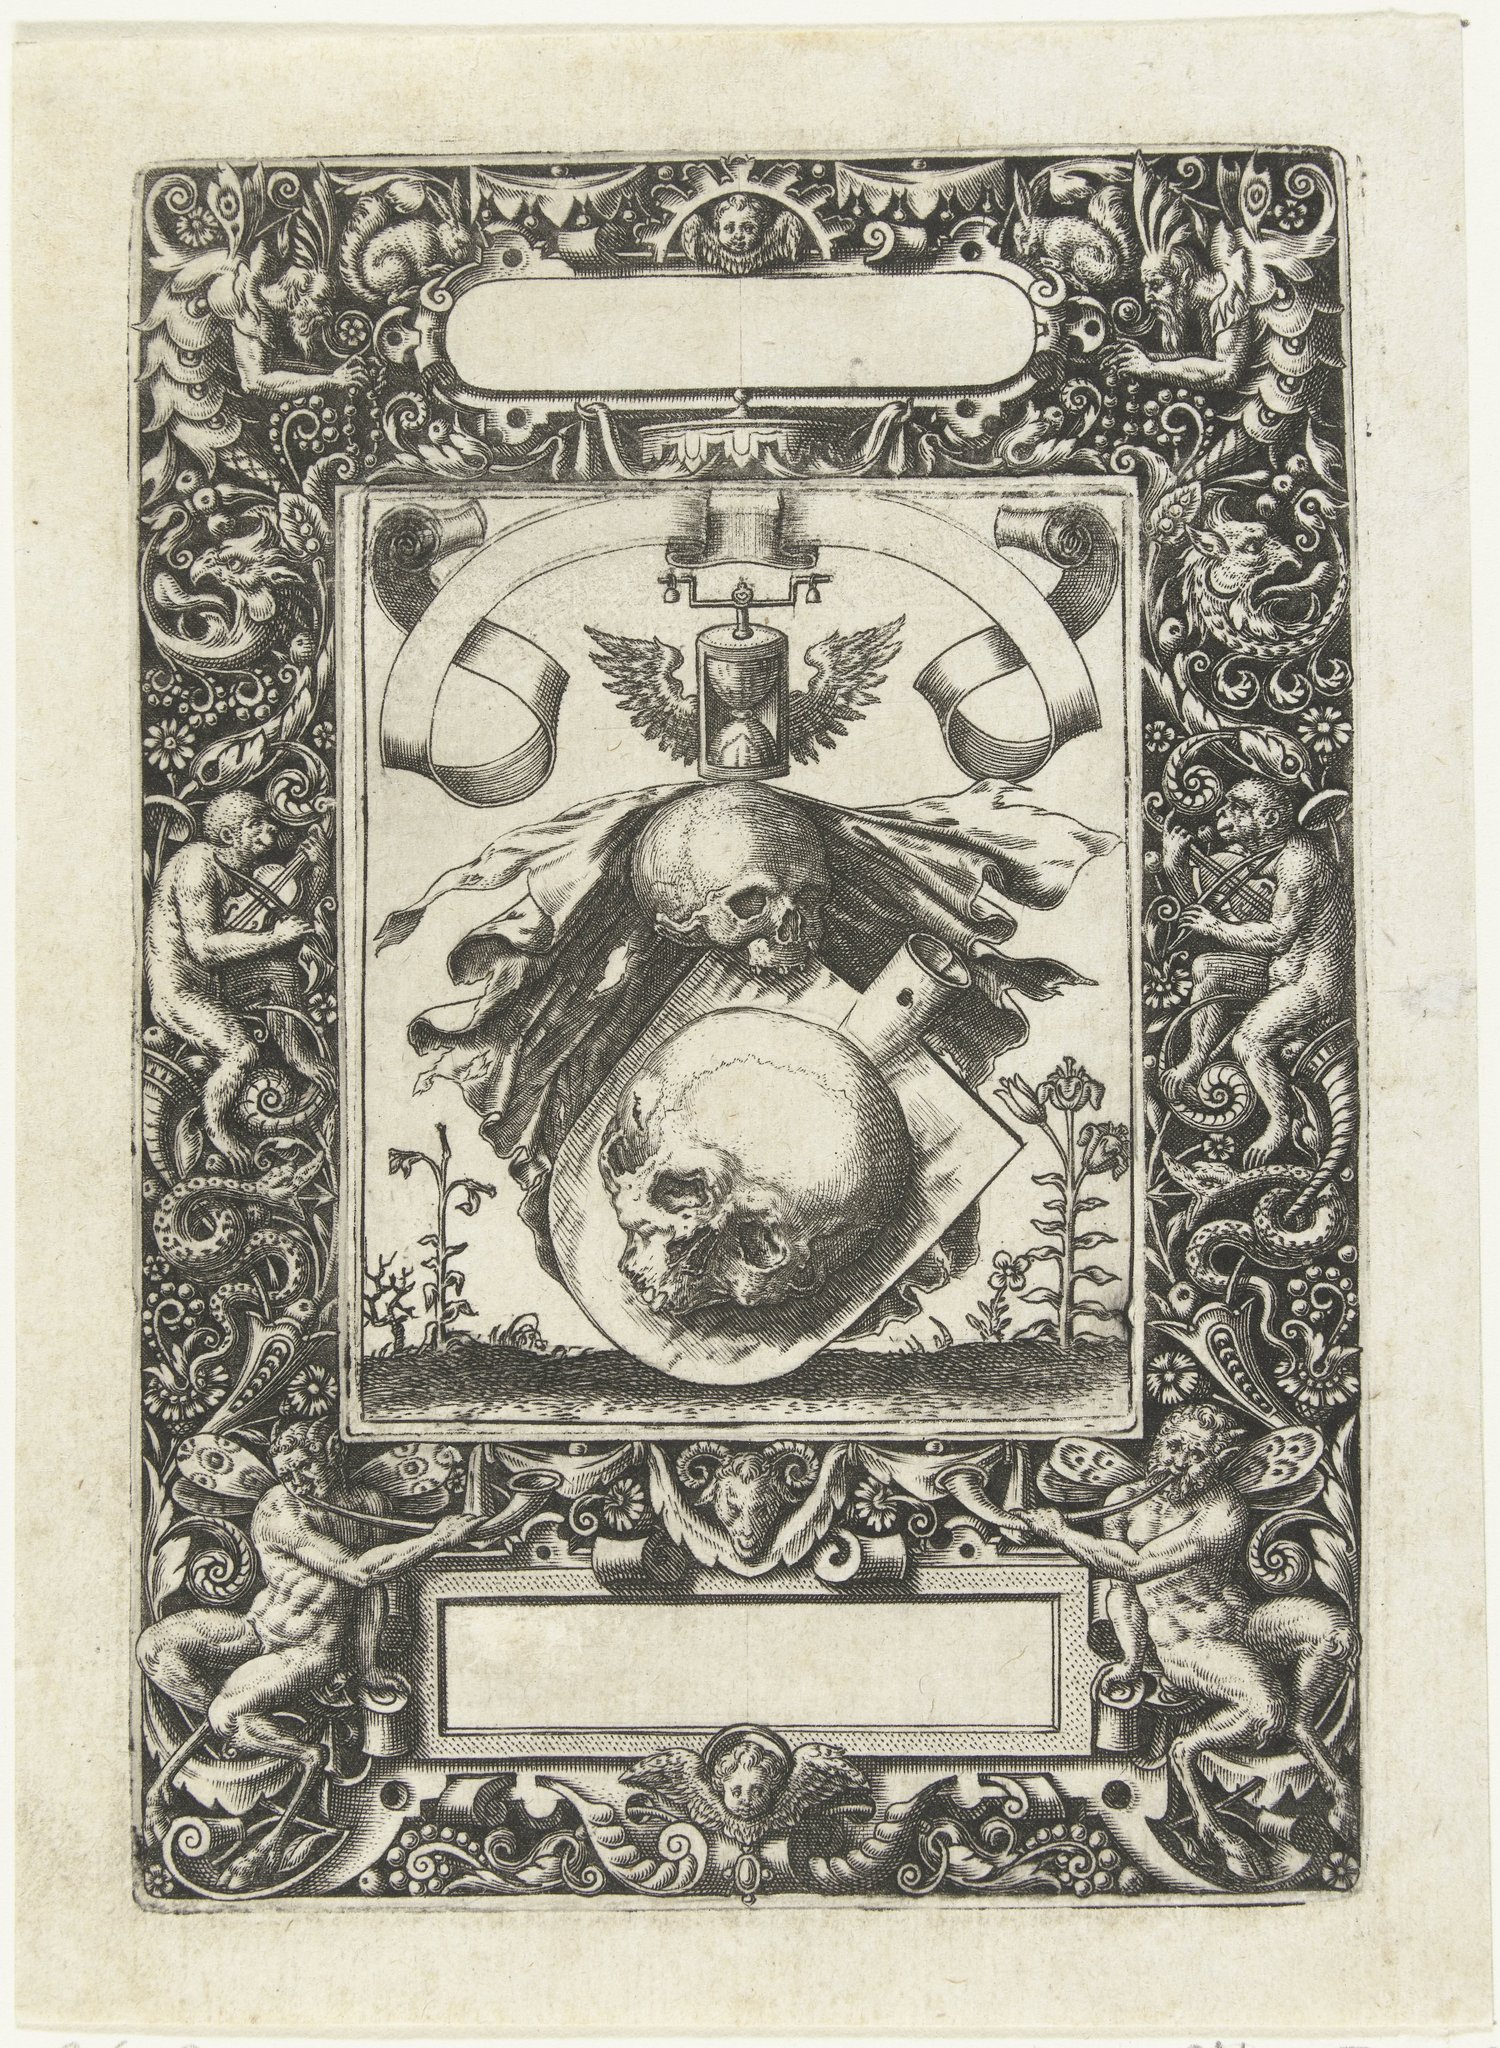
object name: ornament print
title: (4) bladen ornamentprenten, randomlijstingen met groteske plant, dier en menschenfiguren, waartusschen wapenschilden, op losse platen tusschengedrukt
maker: theodor de bry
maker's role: draughtsman, print maker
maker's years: 1528-1598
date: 1593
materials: paper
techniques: engraving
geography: netherlands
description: Middenonder een rechthoekige cartouche. Links en rechts in het midden zit aan beide kanten een vioolspelende aap. Hoort bij een serie van 18 bladen waarbij in het midden van aparte platen zevenentwintig emblemata en vijfenveertig wapenschilden zijn gedrukt. De emblemata zijn ten dele genummerd A-D, 1-7 en 9-21. Drie bladen hebben geen nummer. De wapenschilden, die deels dubbel zijn afgedrukt, zijn ongenummerd.